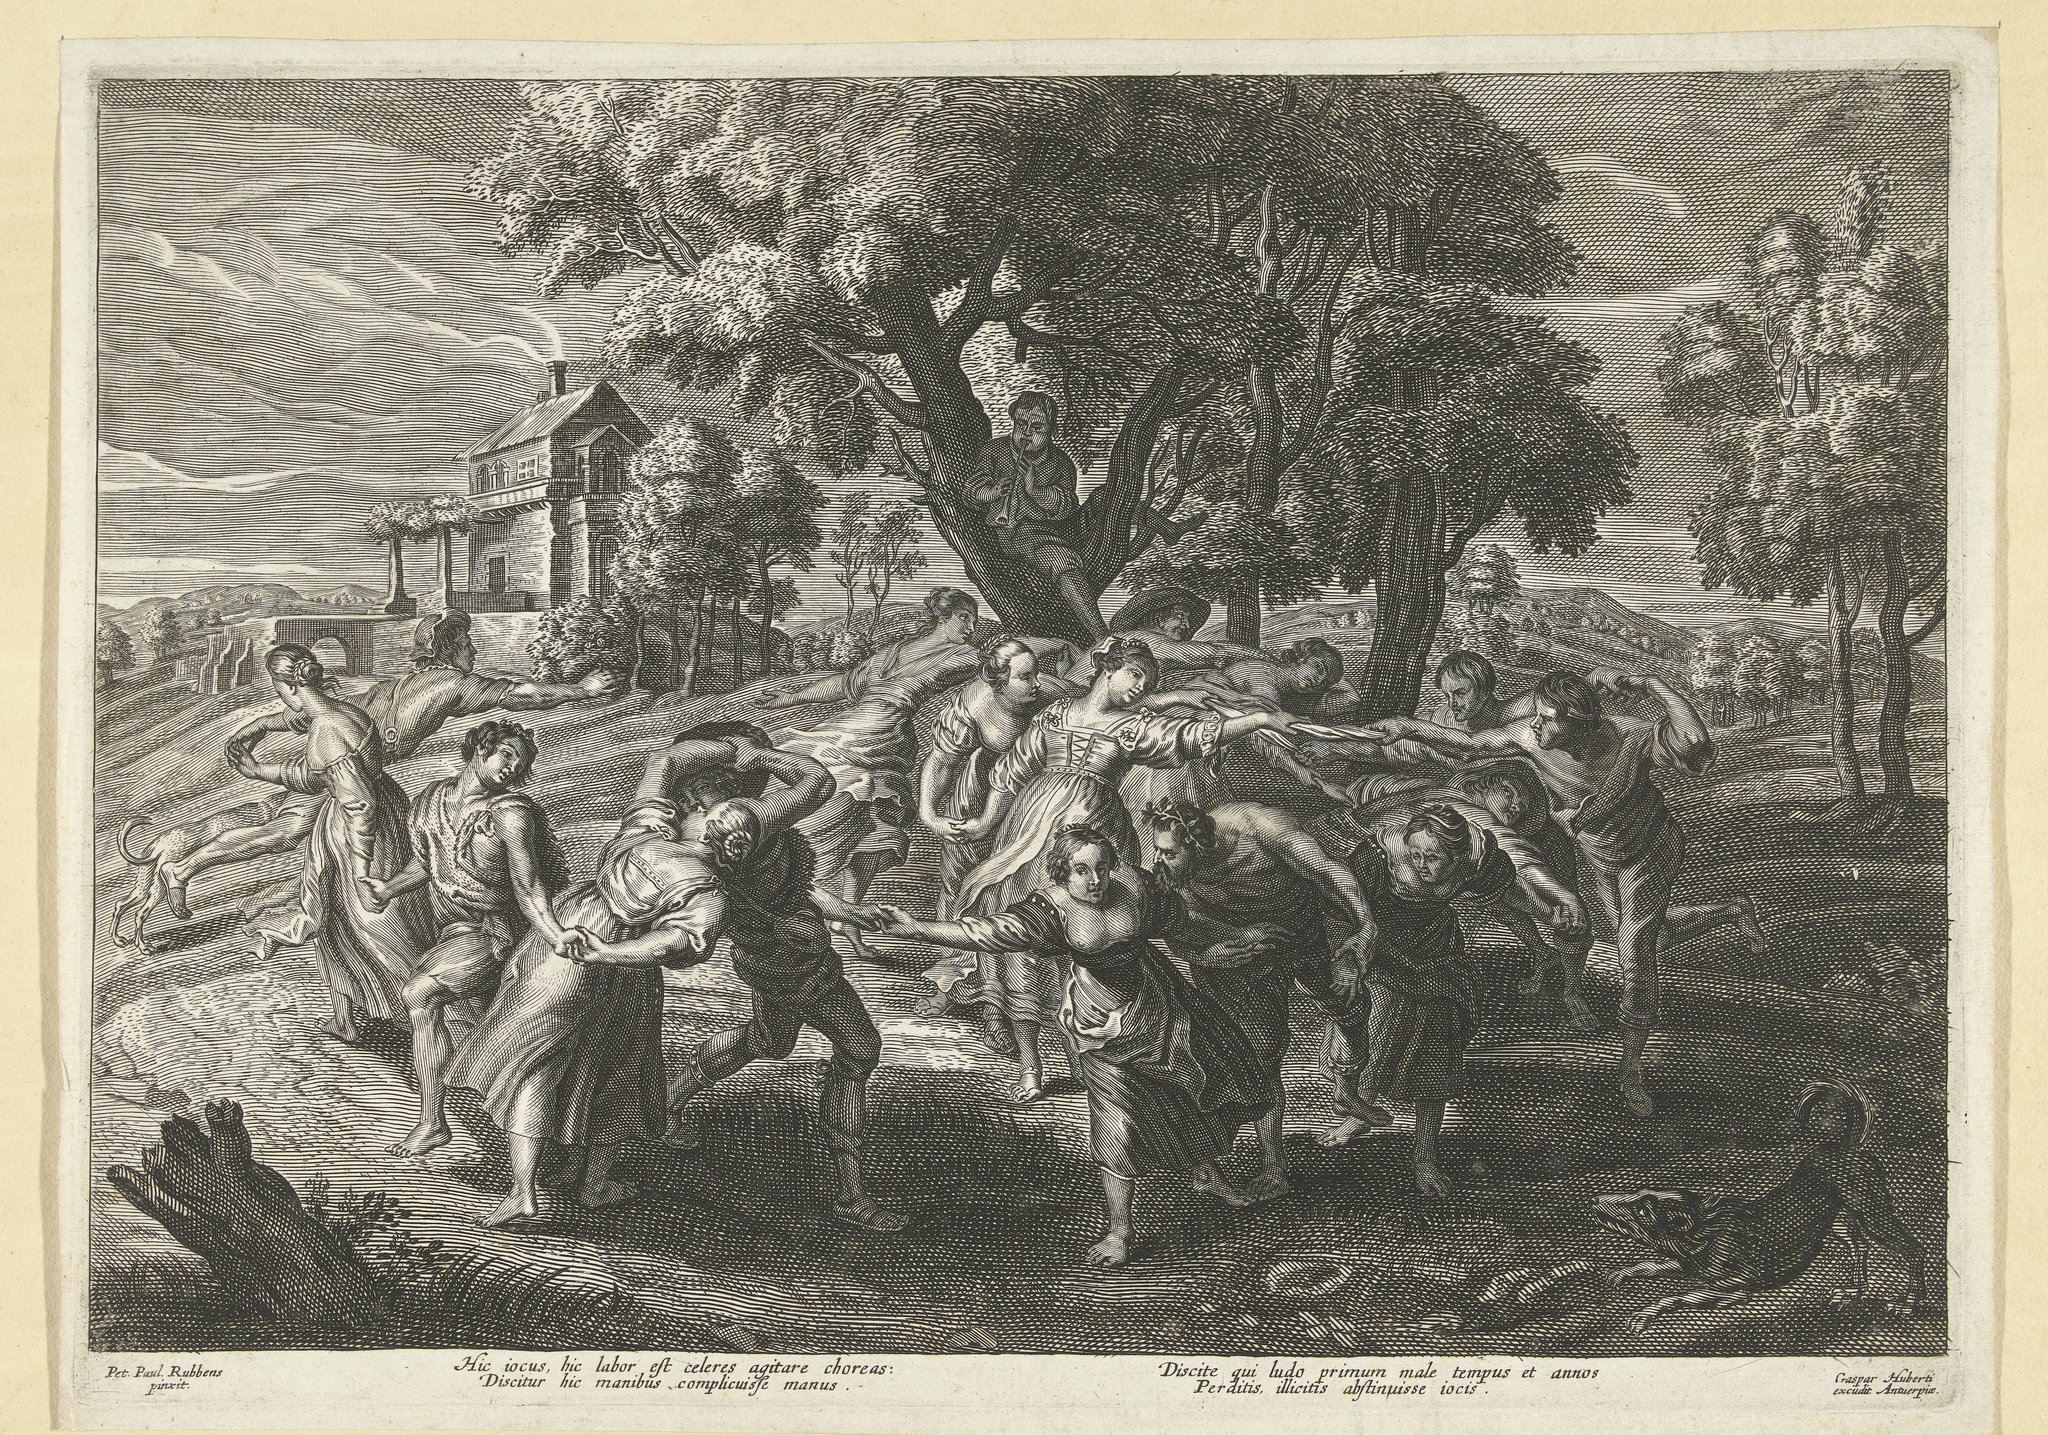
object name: print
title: Landschap met mannen en vrouwen die dansen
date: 1596-1684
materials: paper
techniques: engraving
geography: antwerp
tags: group dancing, private festivities, merry company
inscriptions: collector's mark: Lugt 240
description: Landschap met vrolijk gezelschap van mannen en vrouwen die dansen op muziek van een fluitspeler die zit in een boom. De mannen proberen kussen te stelen van de dames. Onder de voorstelling staat een vers in Latijn.